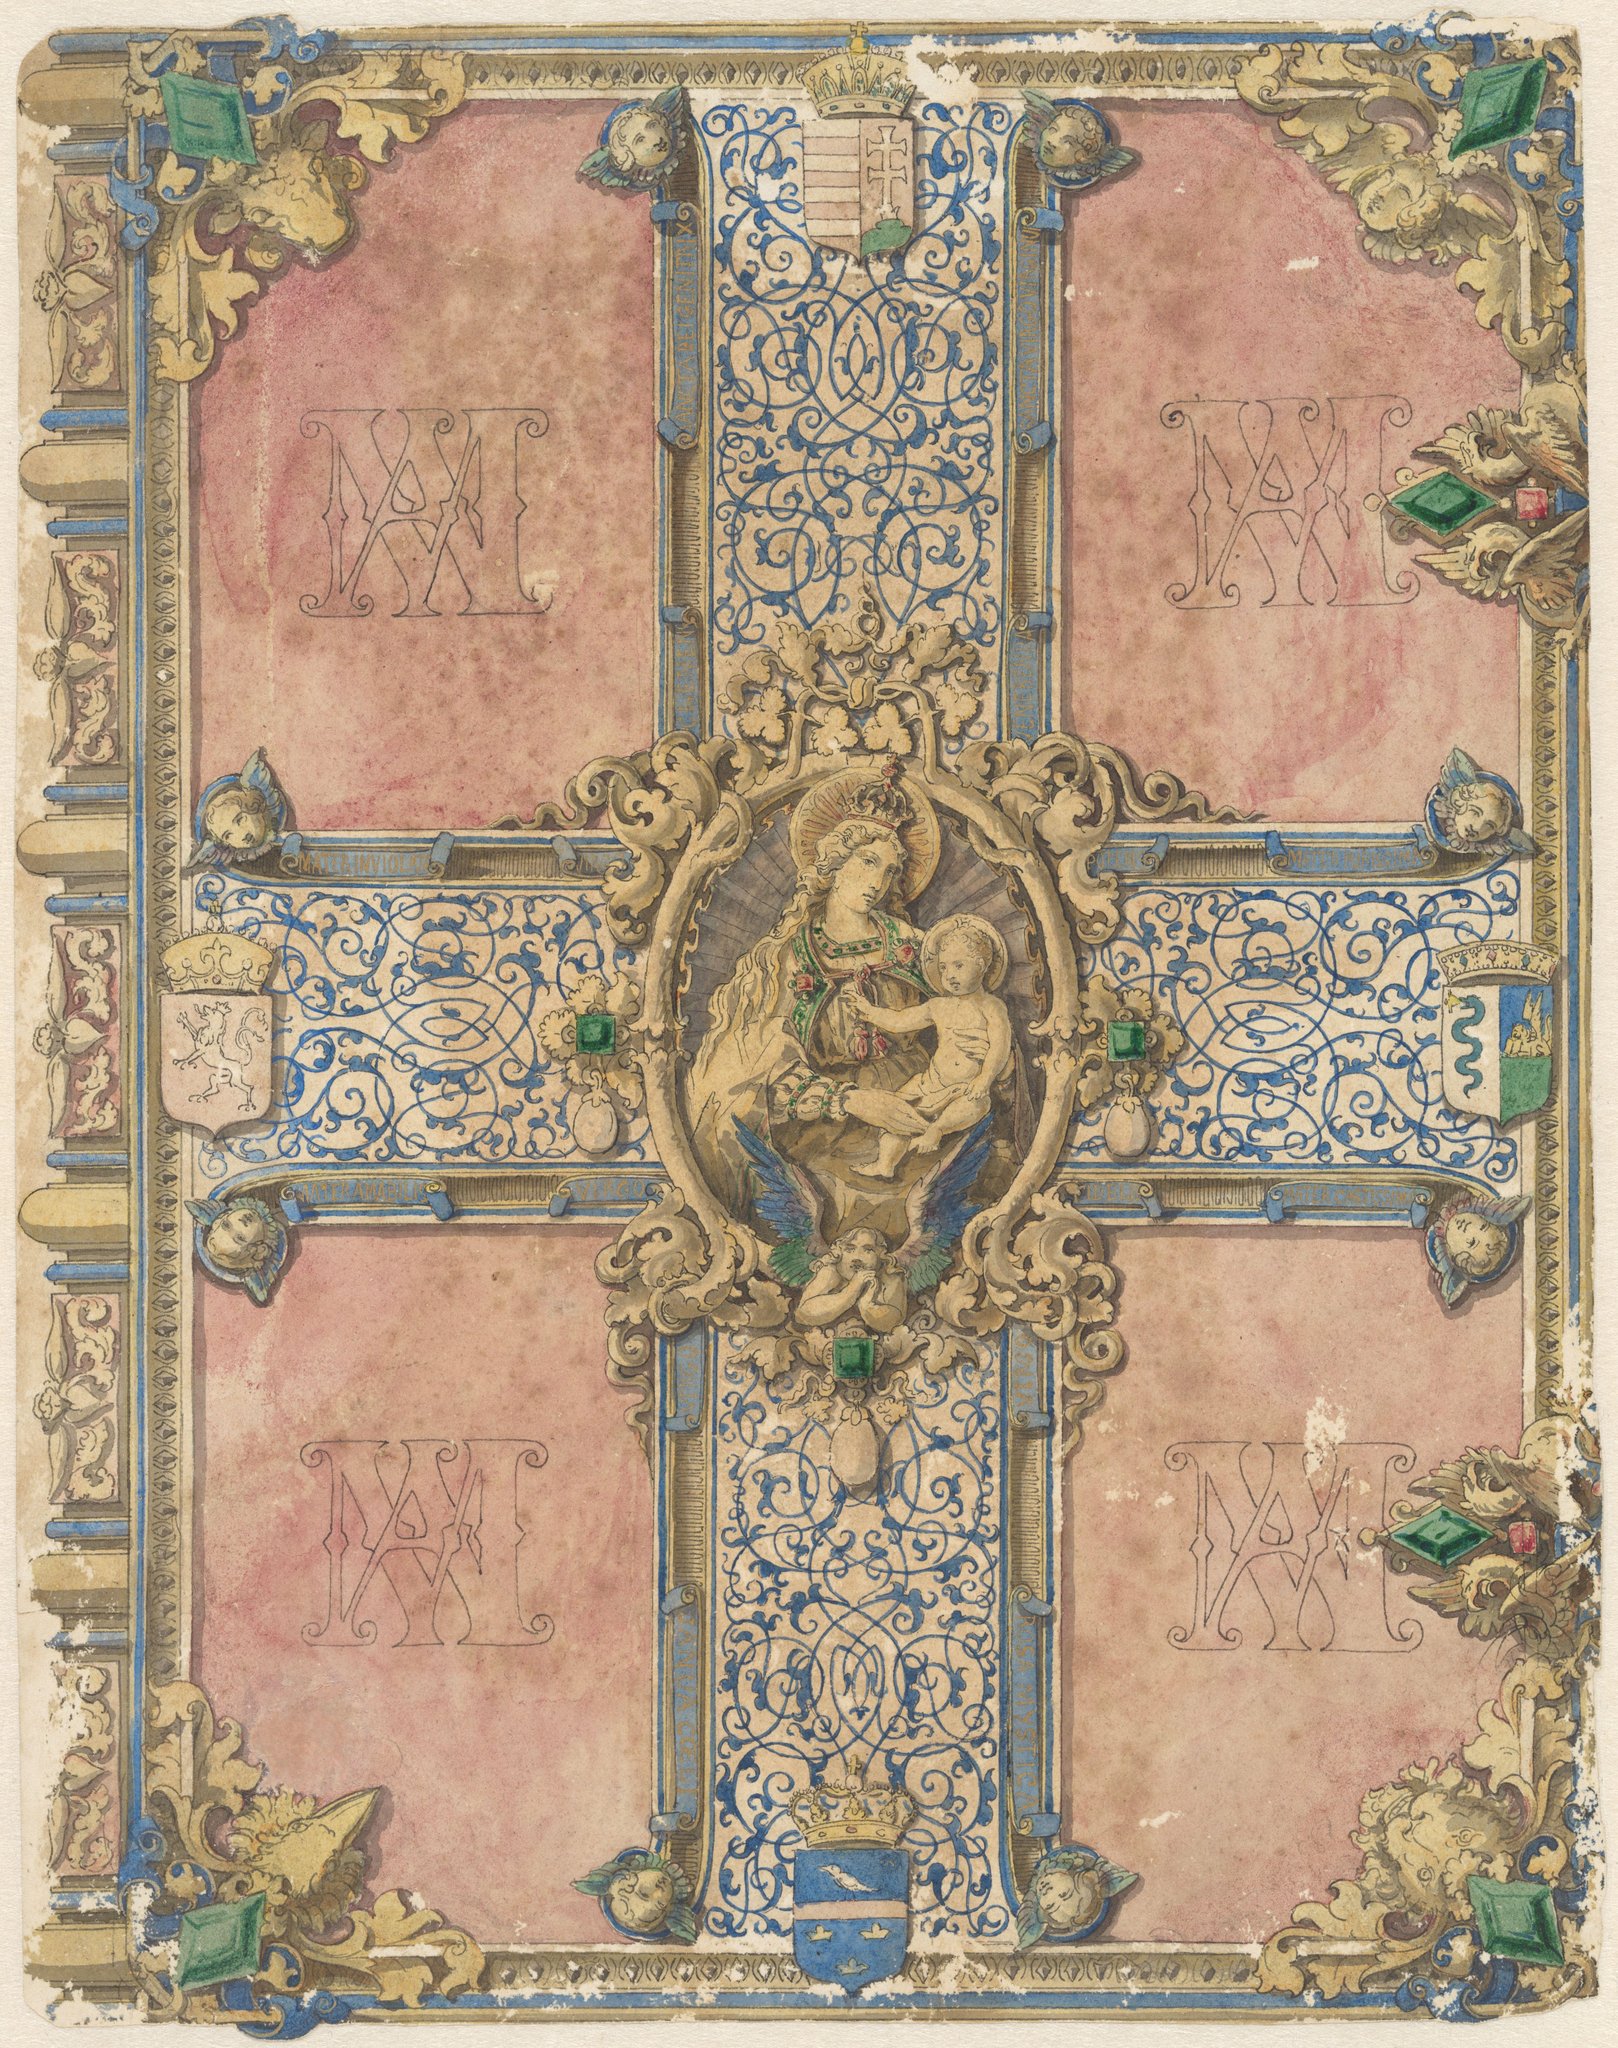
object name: design drawing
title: Ontwerp voor een met edelstenen bezette boekband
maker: frédéric-jules rudolphi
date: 1845-1860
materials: cardboard, gold, ink, paper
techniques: brush, pen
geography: paris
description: In het midden Madonna met kind, in het midden van iedere zijde een gekroond wapen (dezelfde als op RP-T-2018-812-2 en op de rug van RP-T-2018-812-1), vier keer het monogram MA, en banderoles met de opschriften in goud: SANCTA DEI GENITRIX / SANCTA VIRGO VIRGINUI[S] / CLEMENS / VENERENDA / MATER INVIOLATA / VIRGO / POTENS / MATER PURISSIMA / MATER AMABILIS / VIRGO / FIDELIS / MATER CASTISSIMA / VIRGO / VIRGO / ROSA MYSTICA / JANUA COELI. De klampen zijn afgesneden.